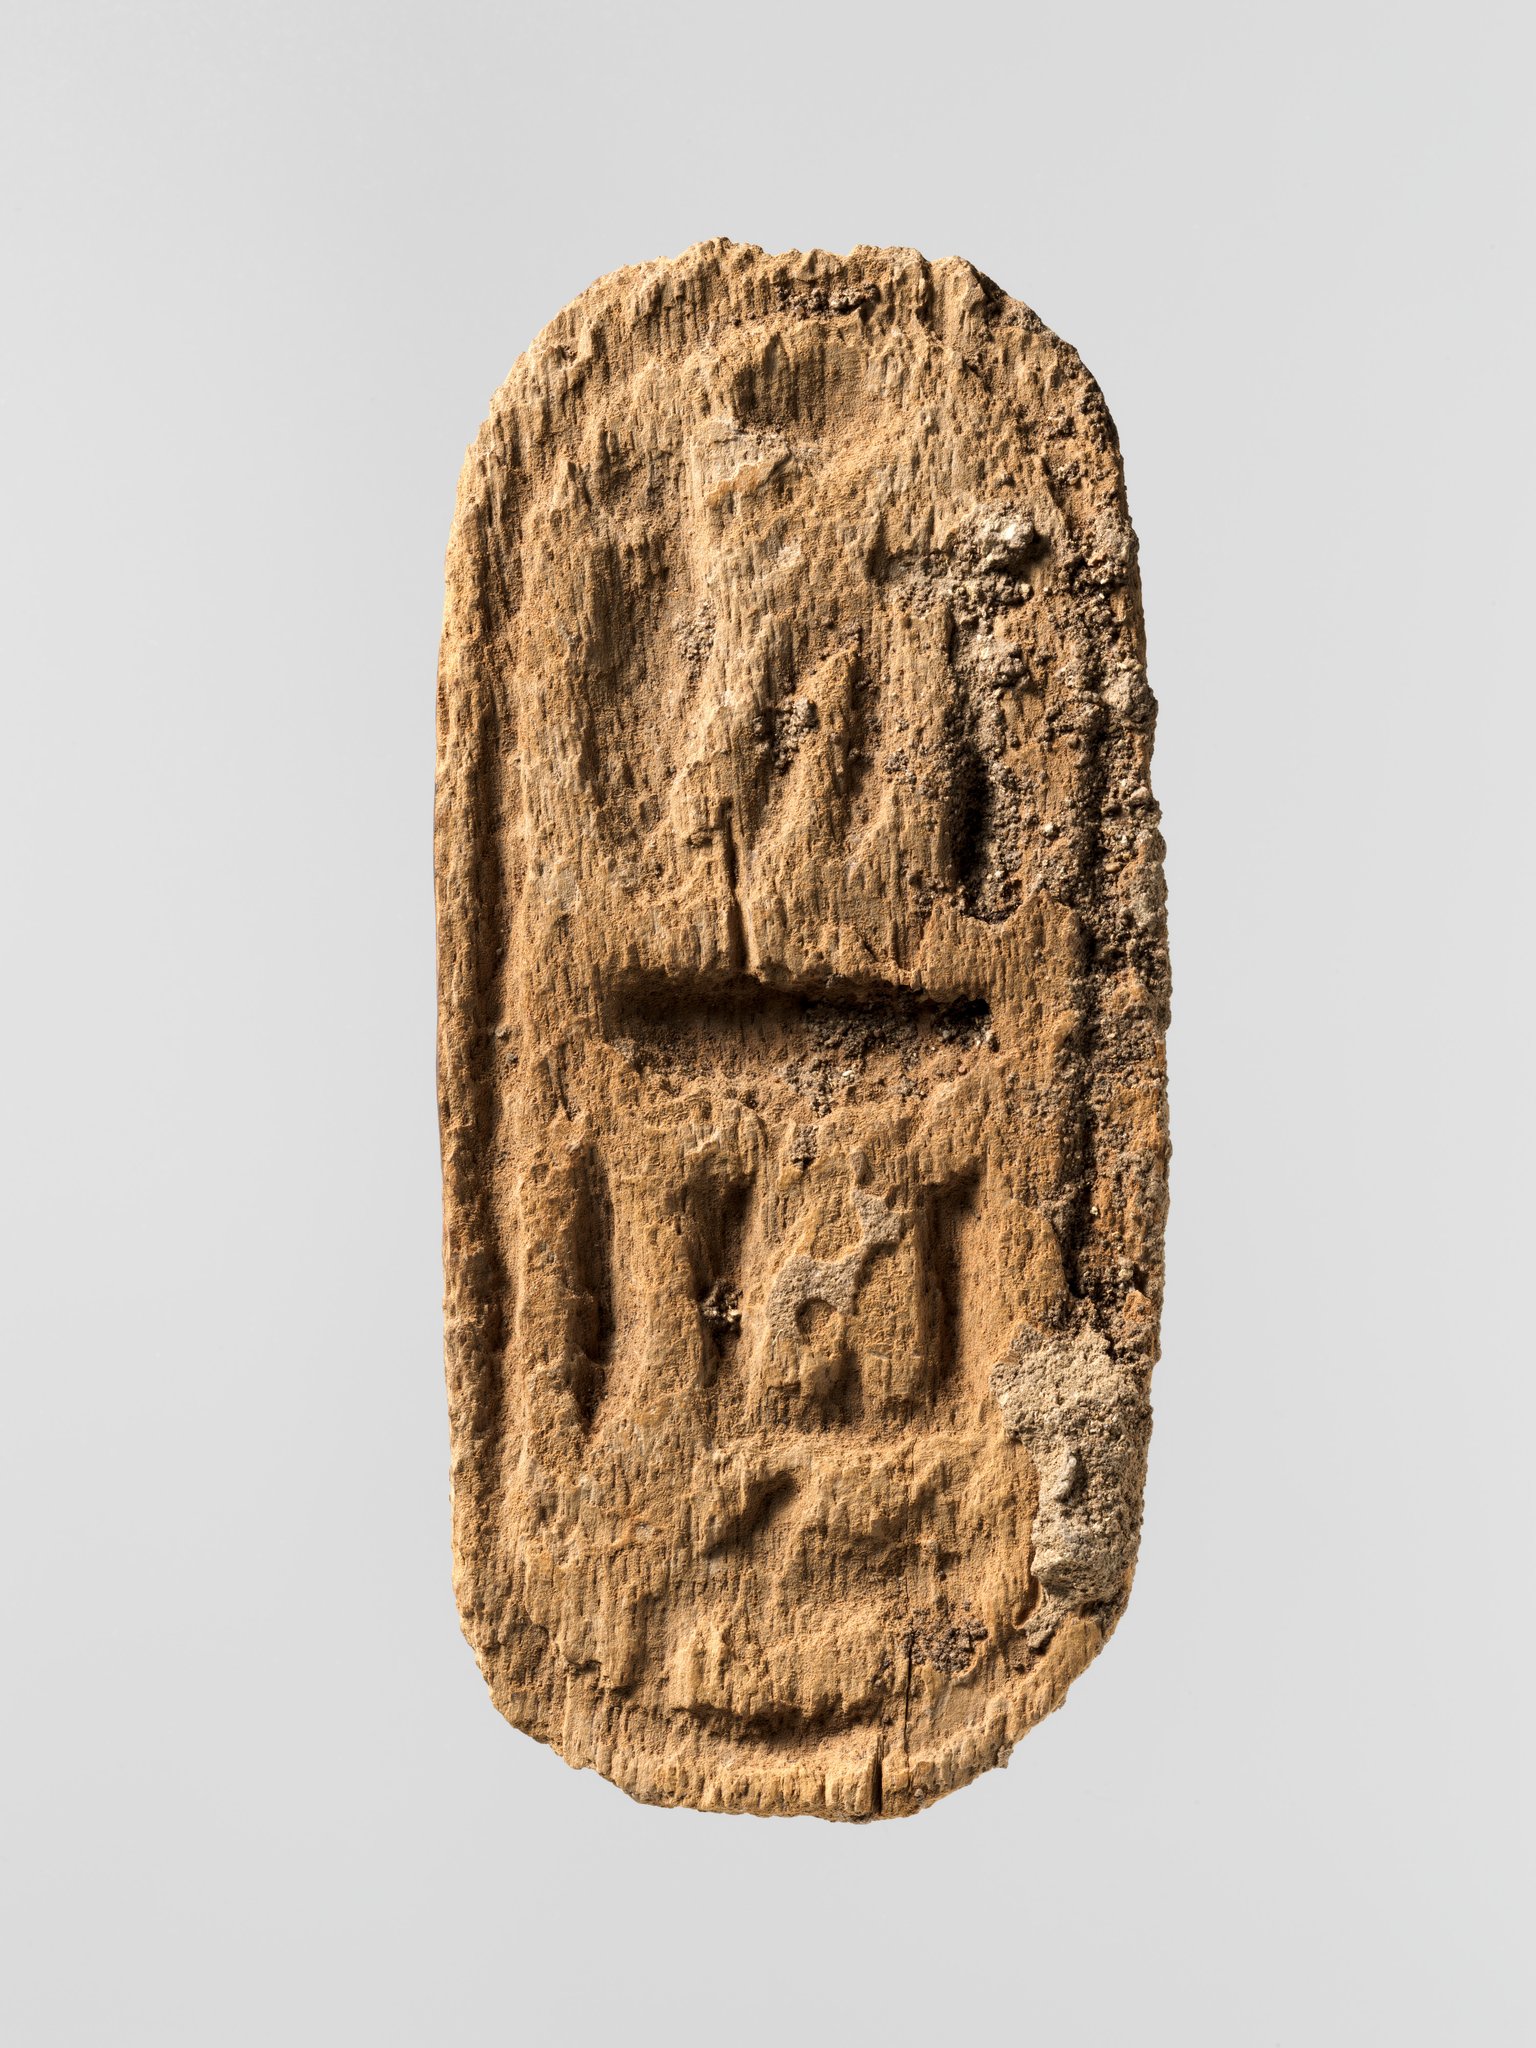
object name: stamp, for brick, renenutet, cobra, epithet, hieroglyph, food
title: Stamp Inscribed for the Goddess Renenutet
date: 1295-1070 BCE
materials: wood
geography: egypt